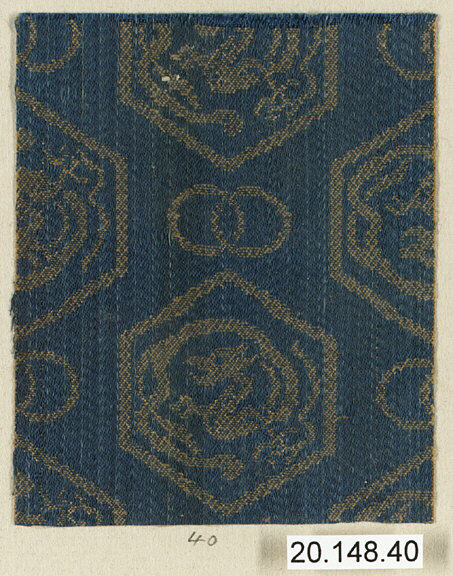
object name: piece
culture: china or japan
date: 1601-1700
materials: silk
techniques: compound weave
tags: dragons